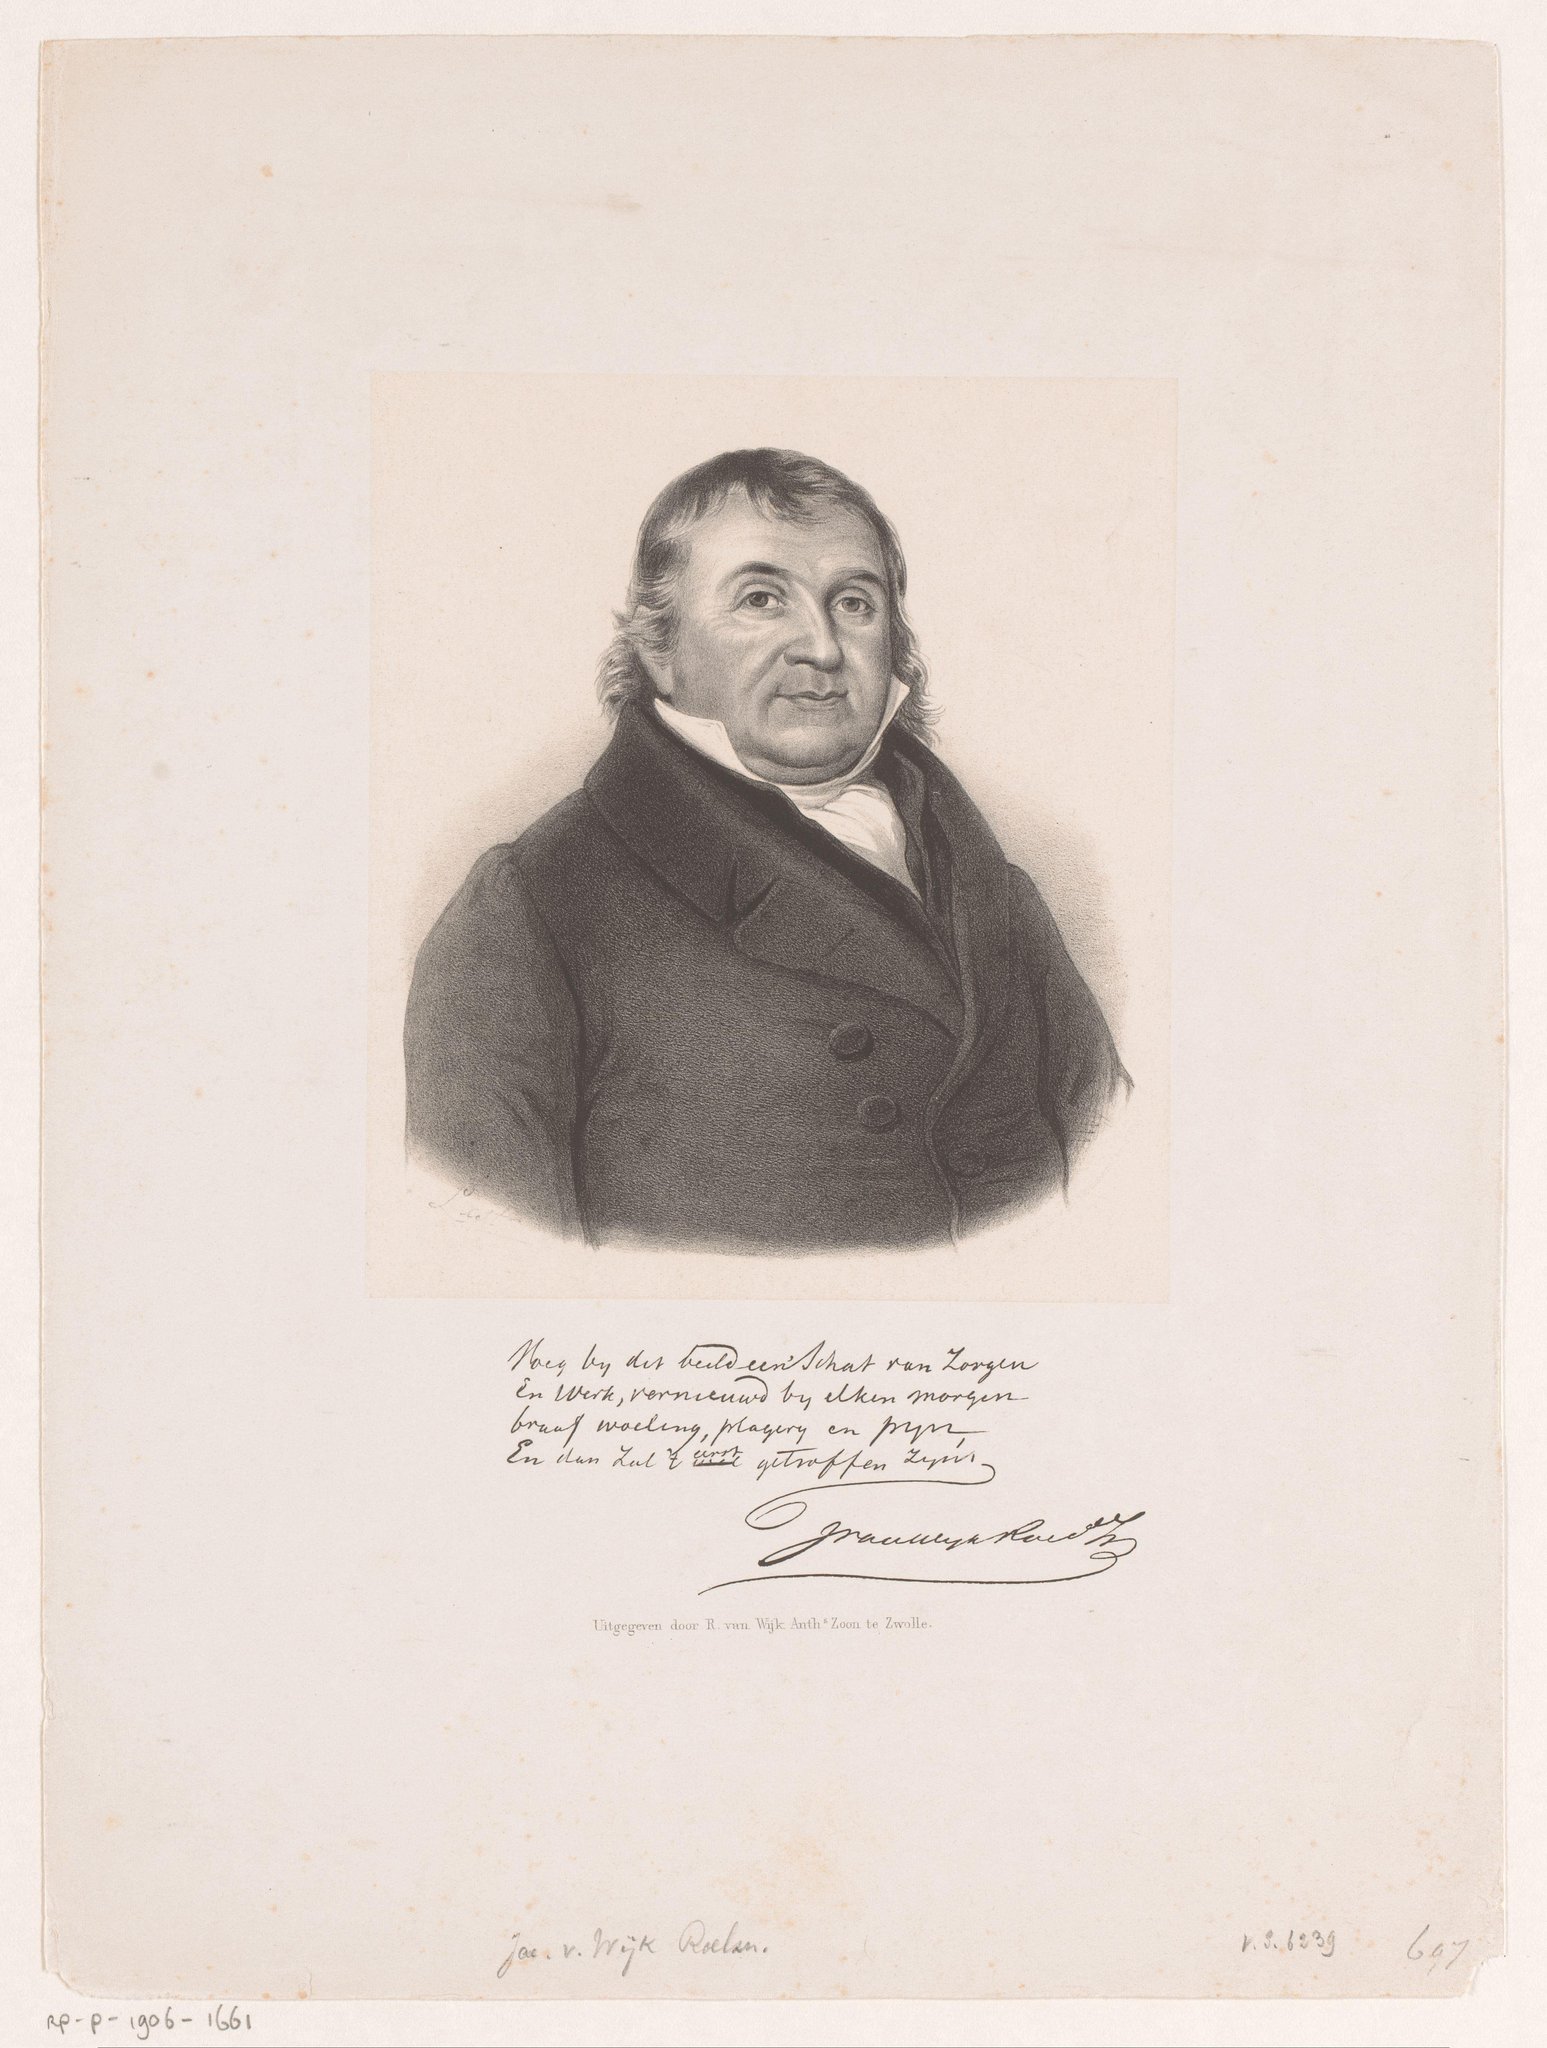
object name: print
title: Portret van Portret van Jacobus van Wijk Roelandszoon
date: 1842-1887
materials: paper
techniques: lithograph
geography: zwolle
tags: historical persons (+ (full) bust portrait)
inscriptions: collector's mark: Lugt 2228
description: Onder het portret een vierregelig gedicht en signatuur.